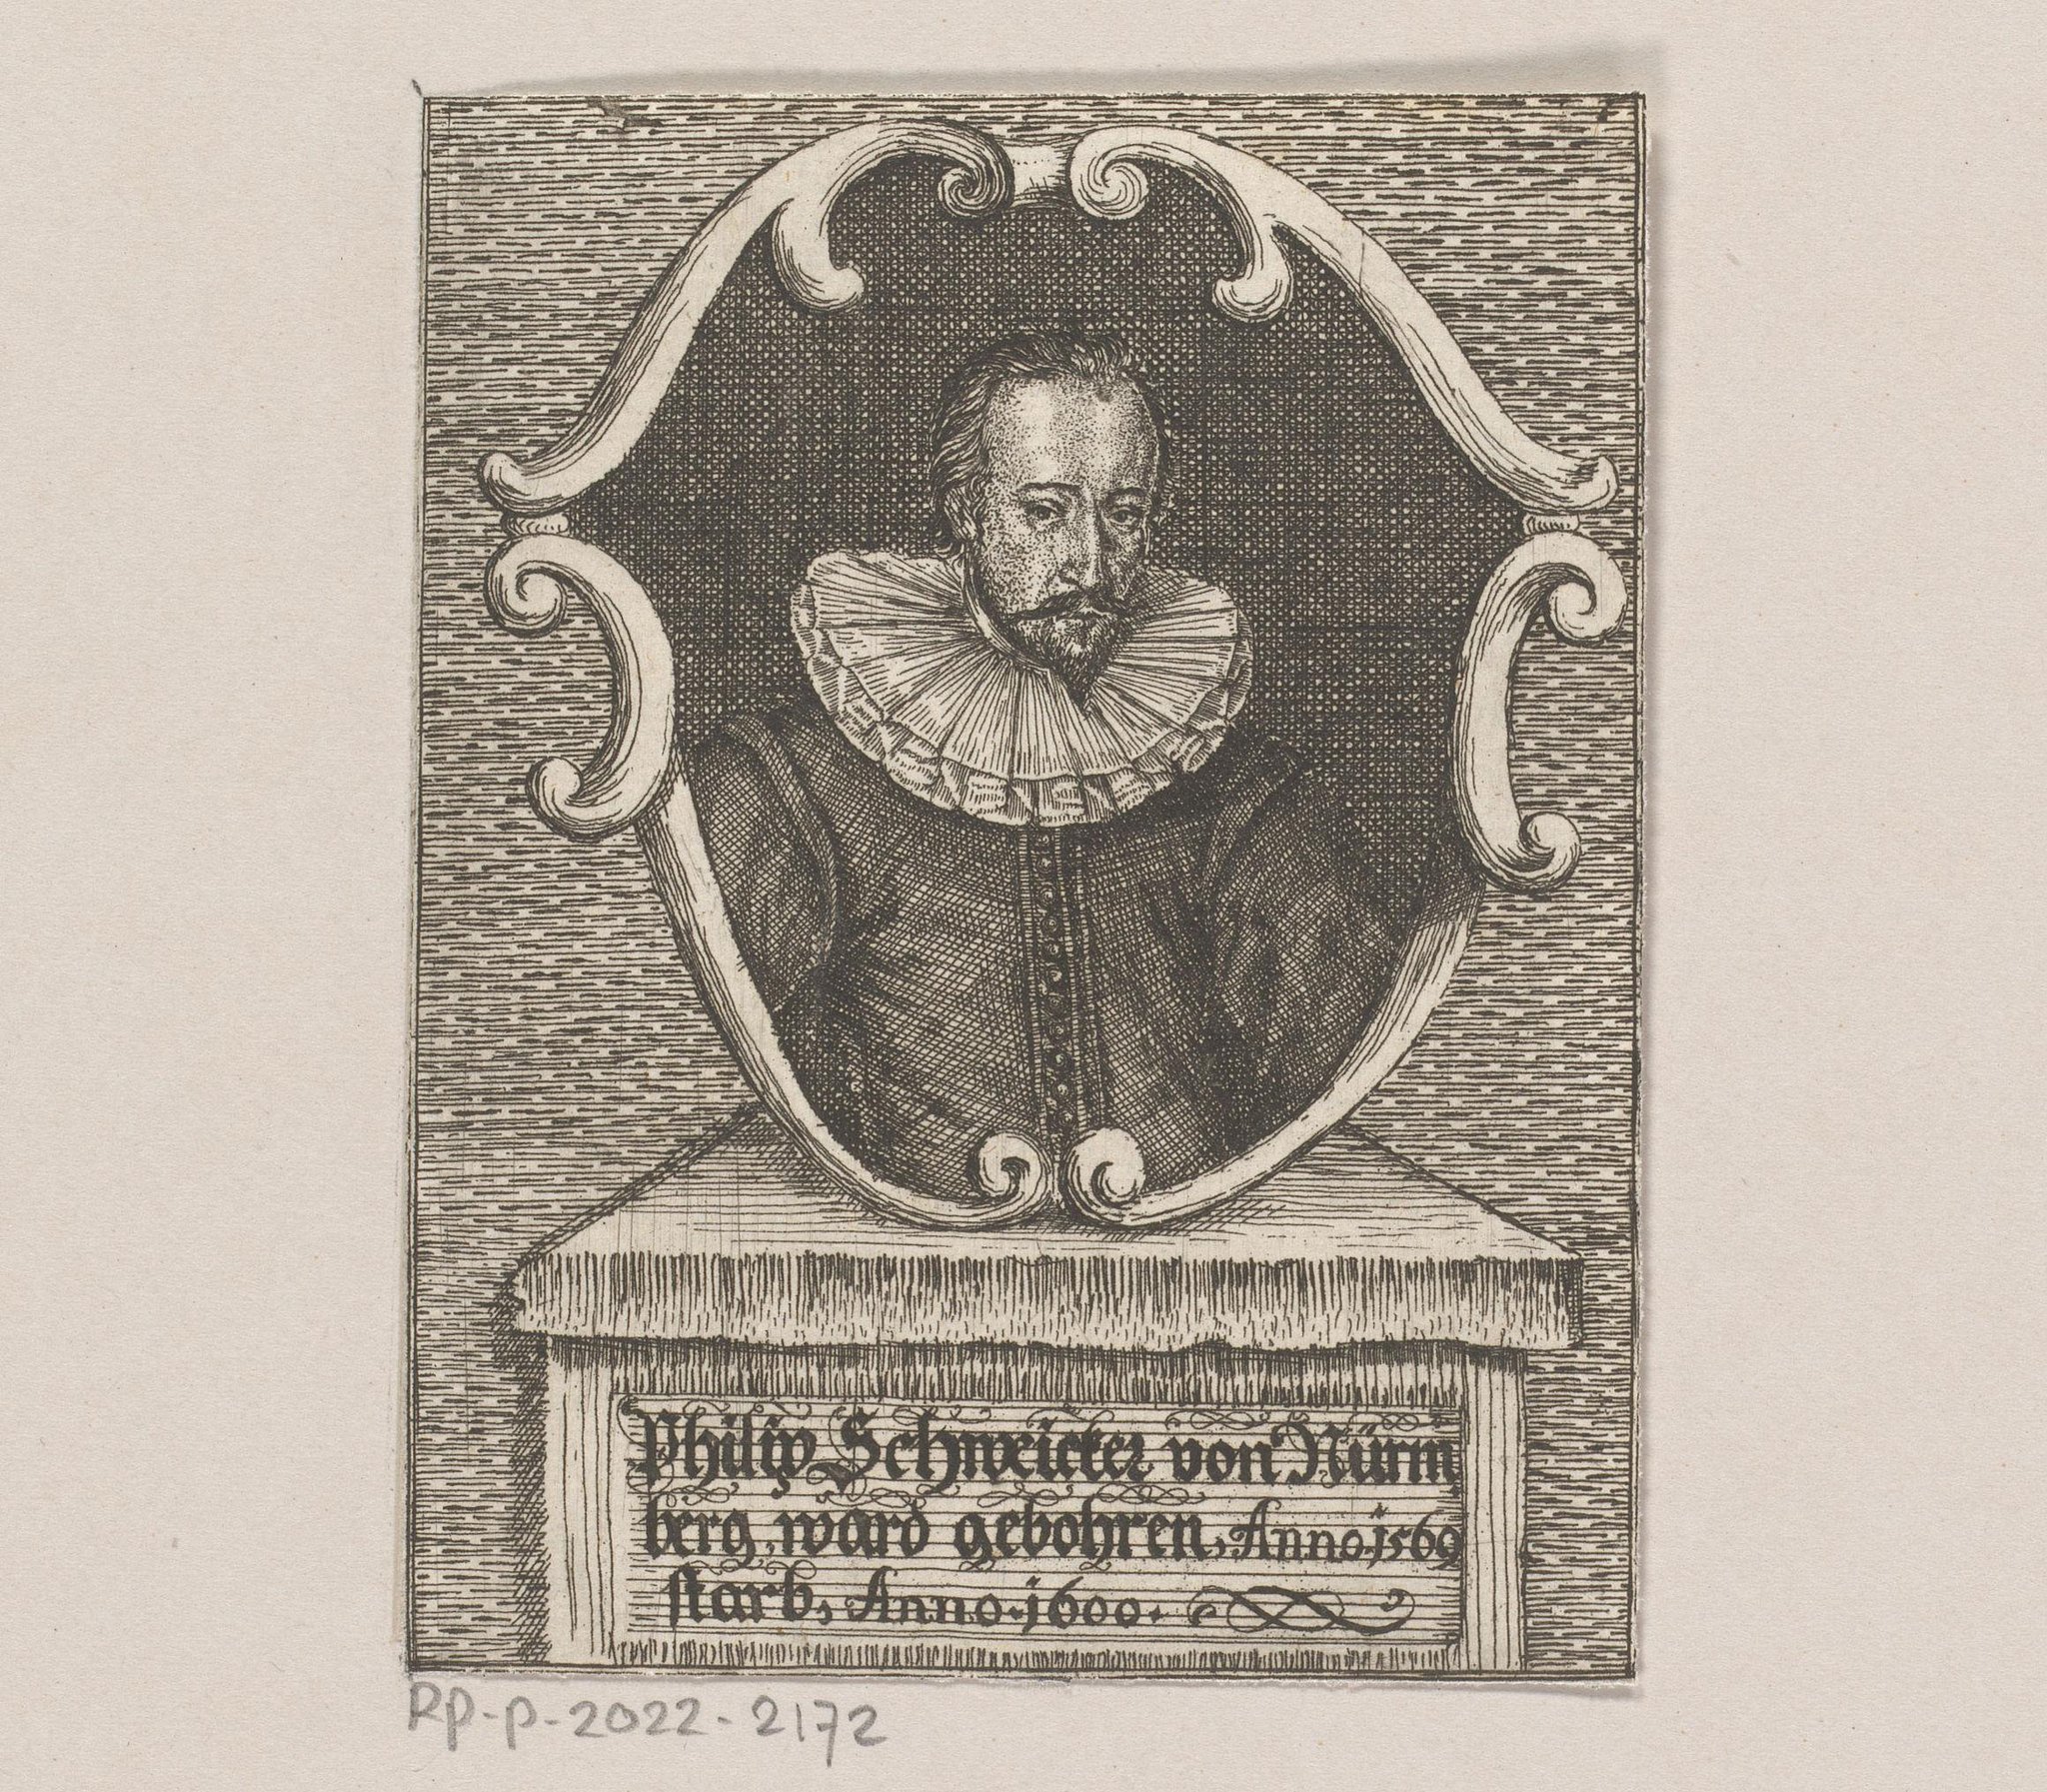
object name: print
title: Portret van Philipp Schweicker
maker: Anonymous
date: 1600-1699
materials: paper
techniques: etching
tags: historical persons, merchant, salesman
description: Met drieregelig onderschrift in het Duits.